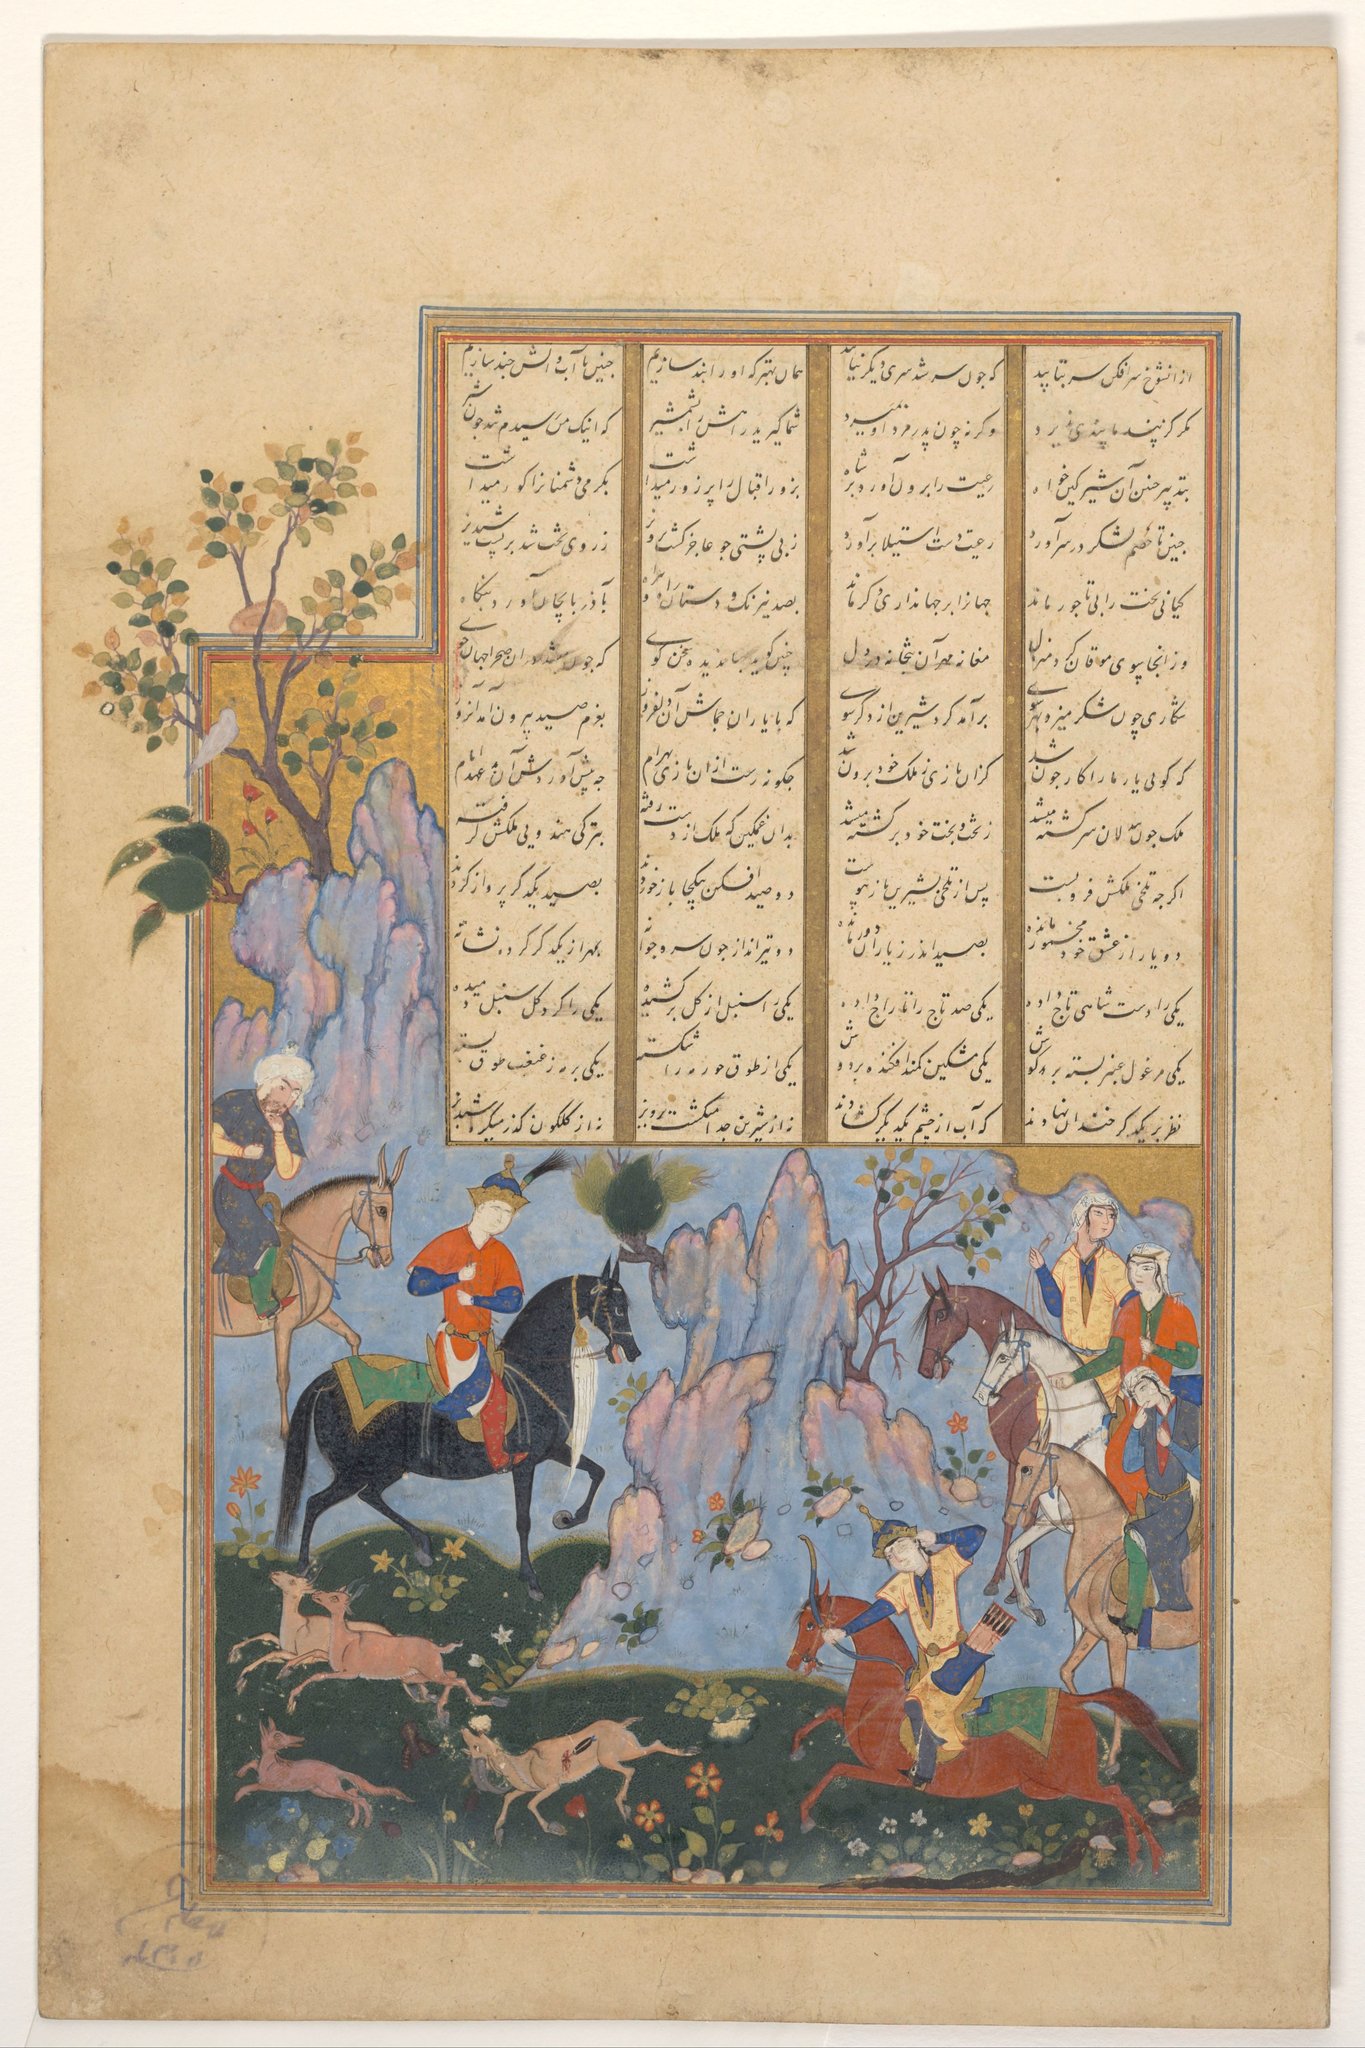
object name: persian miniature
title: Koninklijke jachtpartij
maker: Anonymous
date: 1560-1570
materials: paper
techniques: brush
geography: iran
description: Een groep ruiters in een kloof op hertenjacht; aan de bovenkant van het miniatuur zijn vier verticale stroken tekst aangebracht gescheiden door goudkleurige verticale kolommen. De voorstelling loopt links van de rand tekst nog naar boven door, de boom op de rots spilt boven de rand uit over het blad.